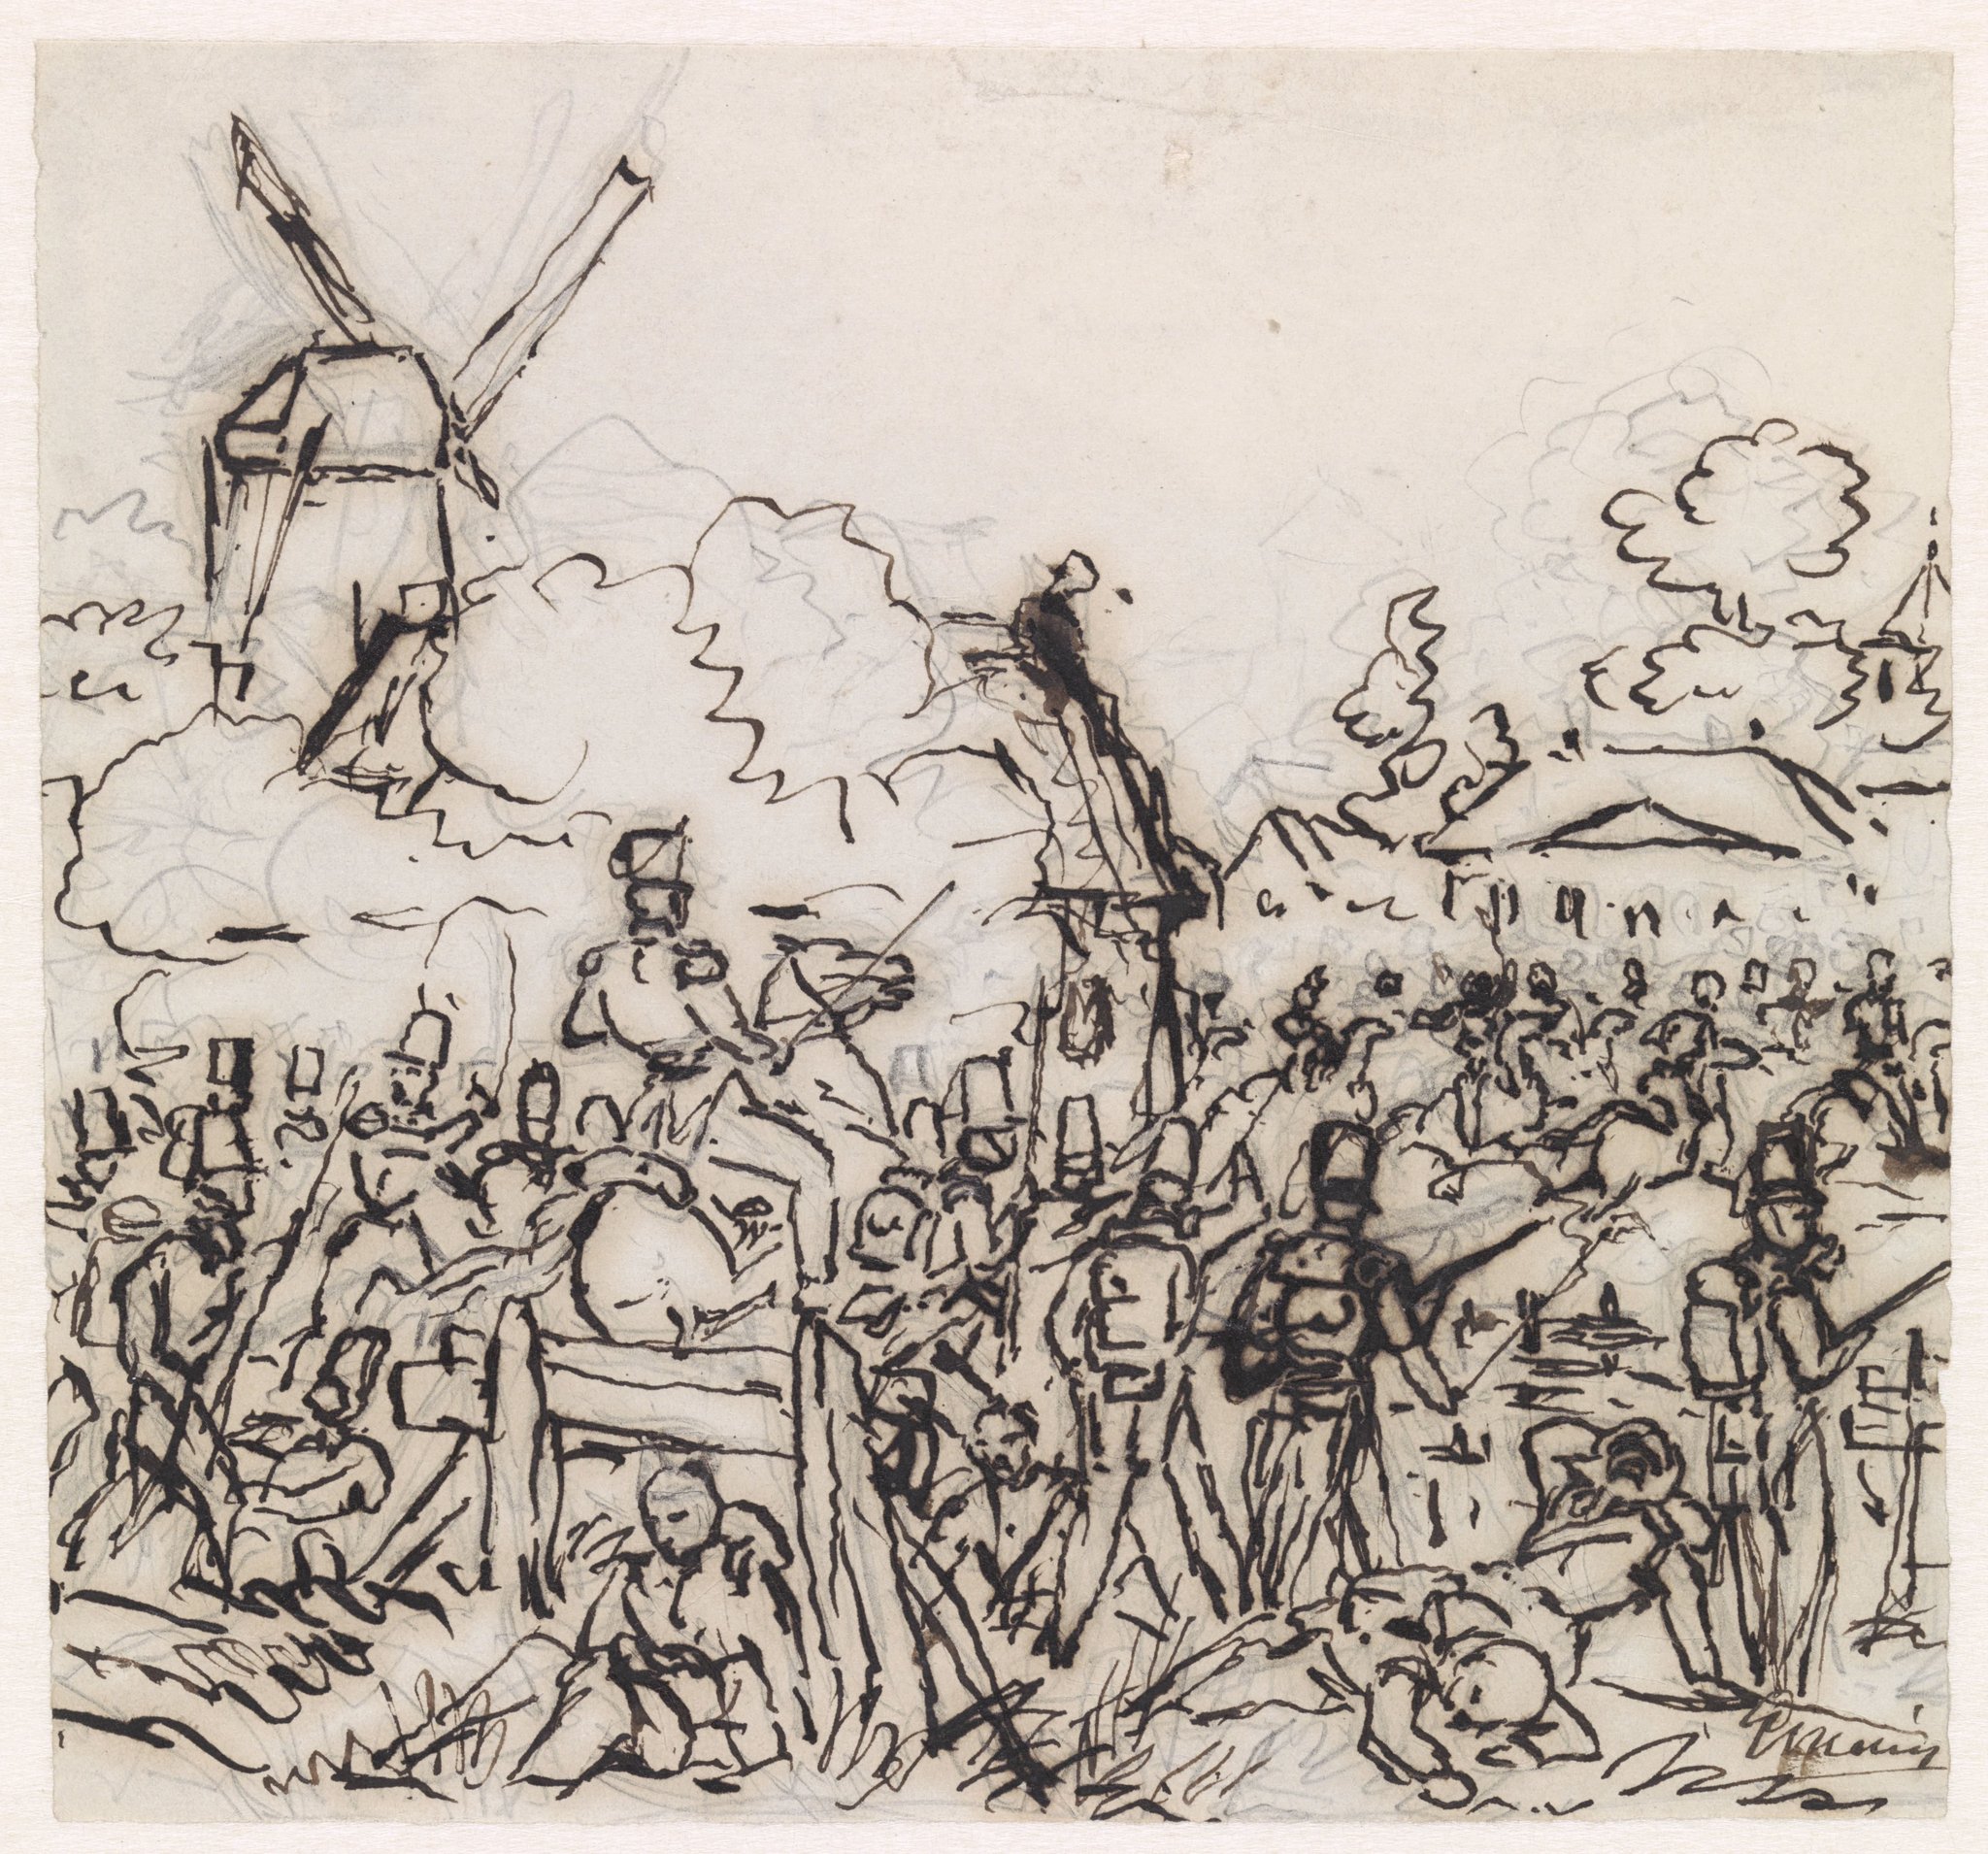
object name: drawing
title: Gevecht bij een dorp, links een windmolen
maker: gerardus emaus de micault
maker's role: draughtsman, print maker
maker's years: 1798-1863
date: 1799-1863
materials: ink, paper, pencil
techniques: pen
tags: battle (+ land forces)